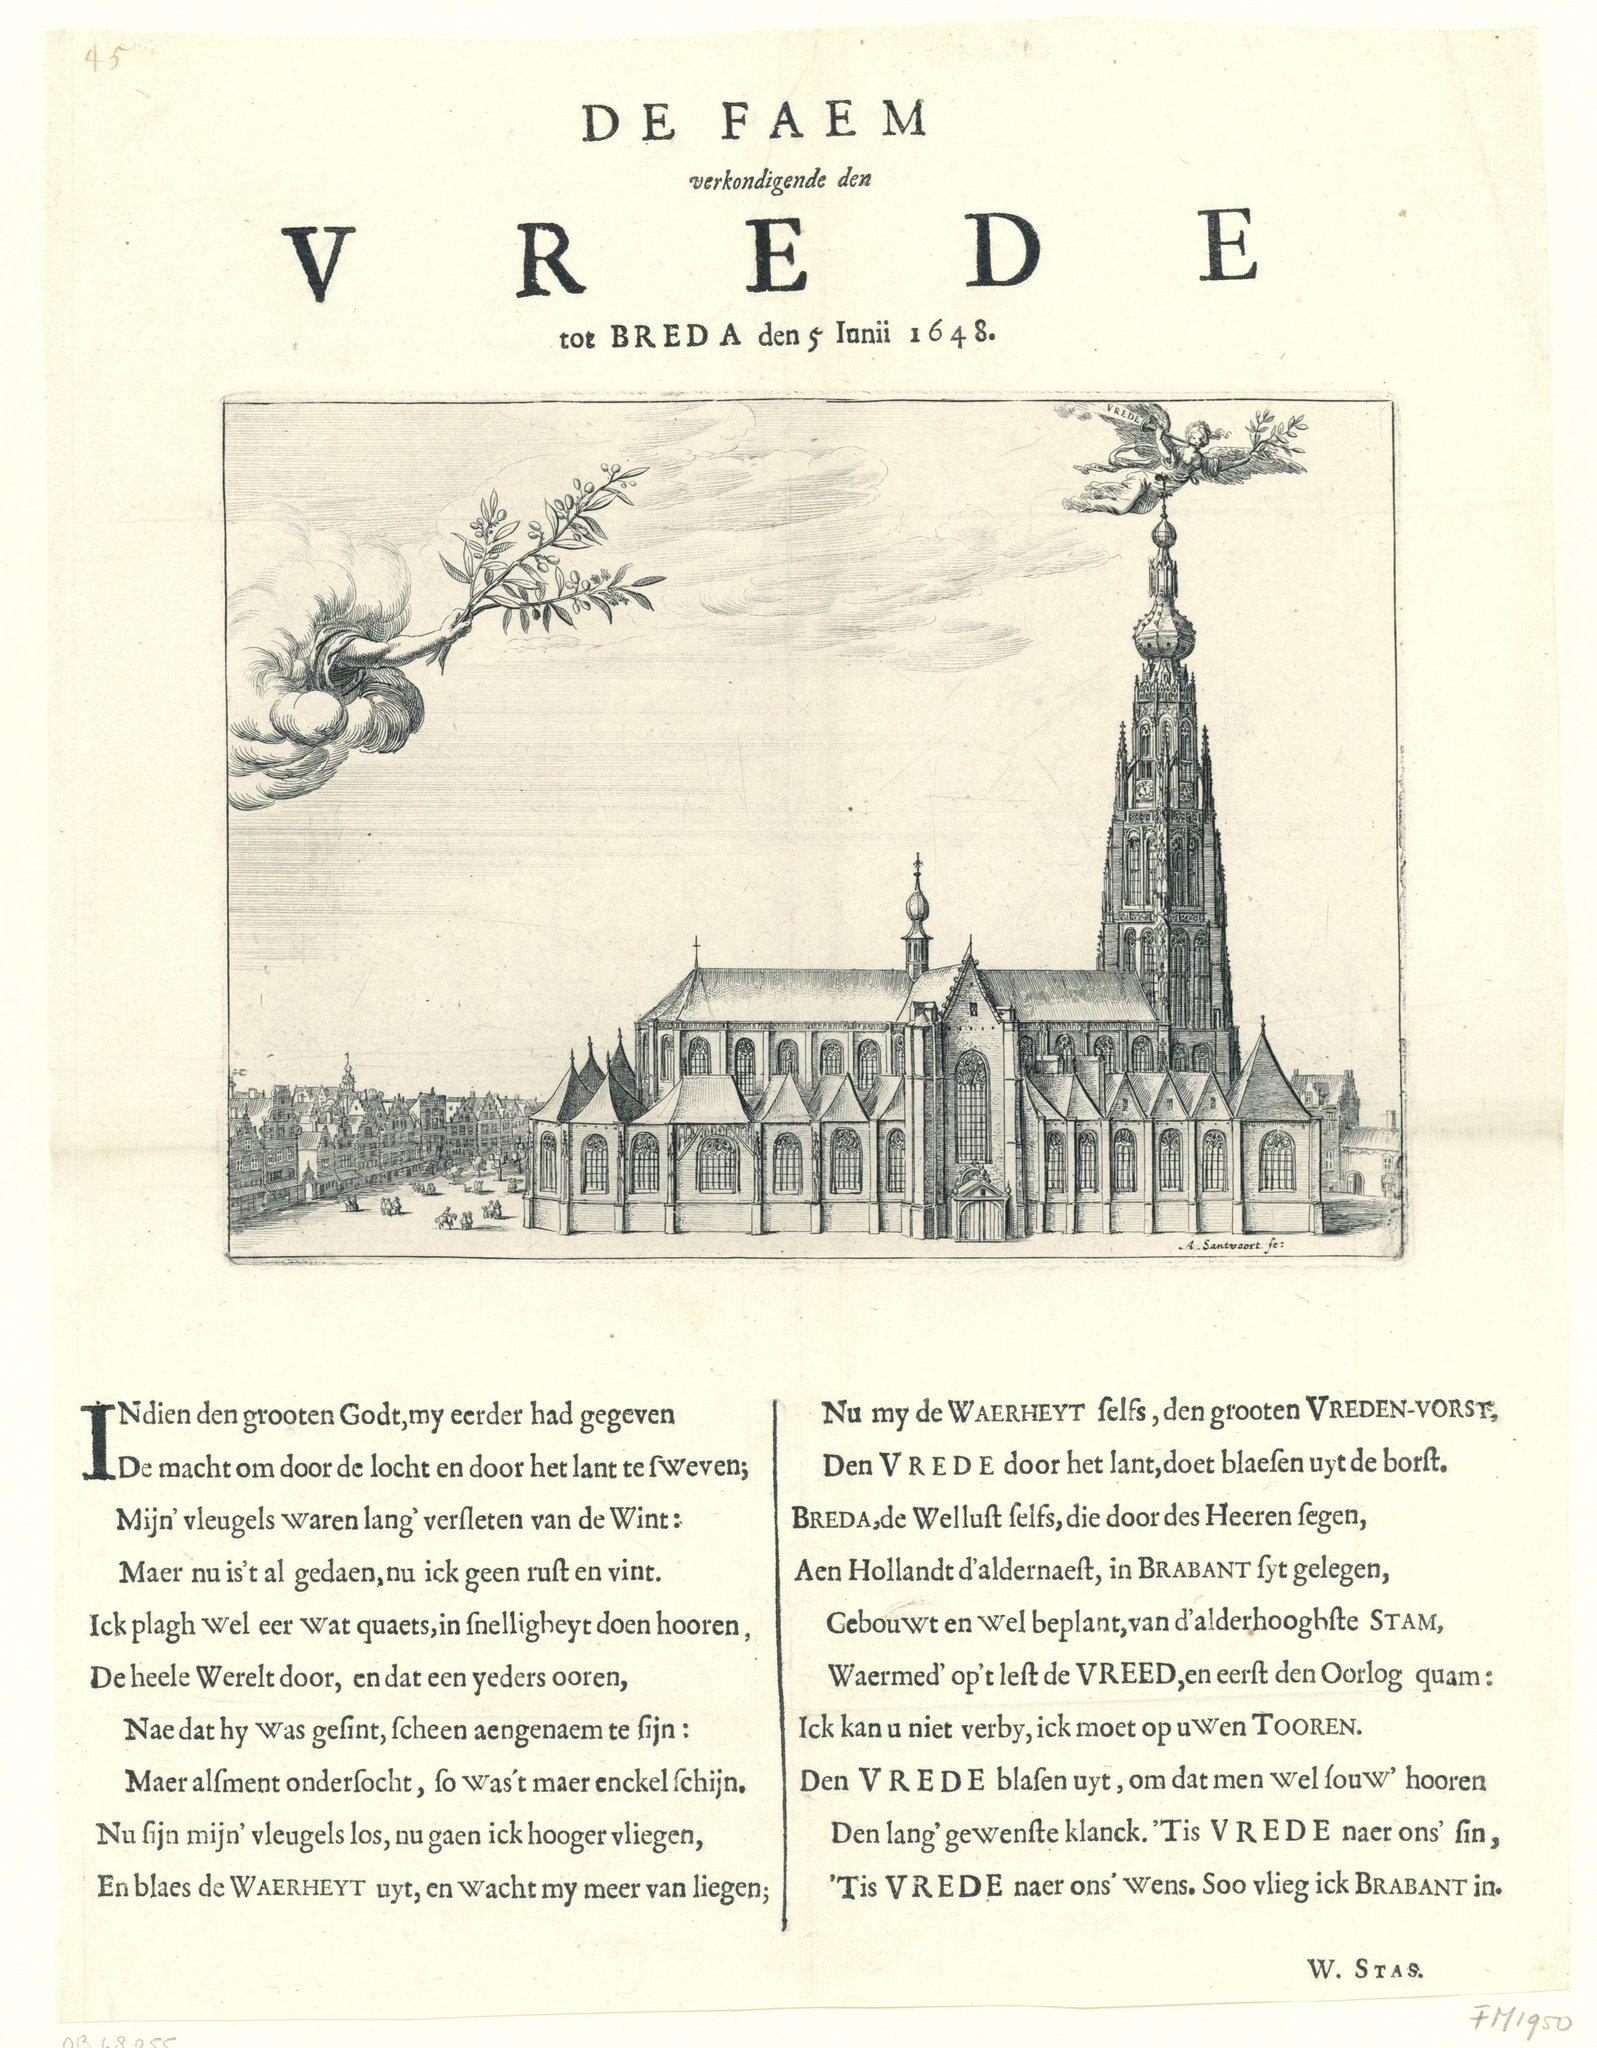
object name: print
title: De Faem verkondigende den Vrede tot Breda den 5 Iunii 1648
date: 1648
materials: paper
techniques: etching, letterpress printing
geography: breda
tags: the place of worship and its equipment ~ christian churches, proclamation of peace, fame; 'fama', 'fama buona', 'fama chiara' (ripa)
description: Afkondiging van de Vrede van Munster te Breda, 5 juni 1648. Gezicht op de Onze-Lieve-Vrouwekerk of Grote Kerk te Breda. Boven de kerktoren de Faam die de vrede verkondigt, links een hand uit de wolken met een olijftak. Onder de voorstelling een Nederlands vers over twee kolommen.